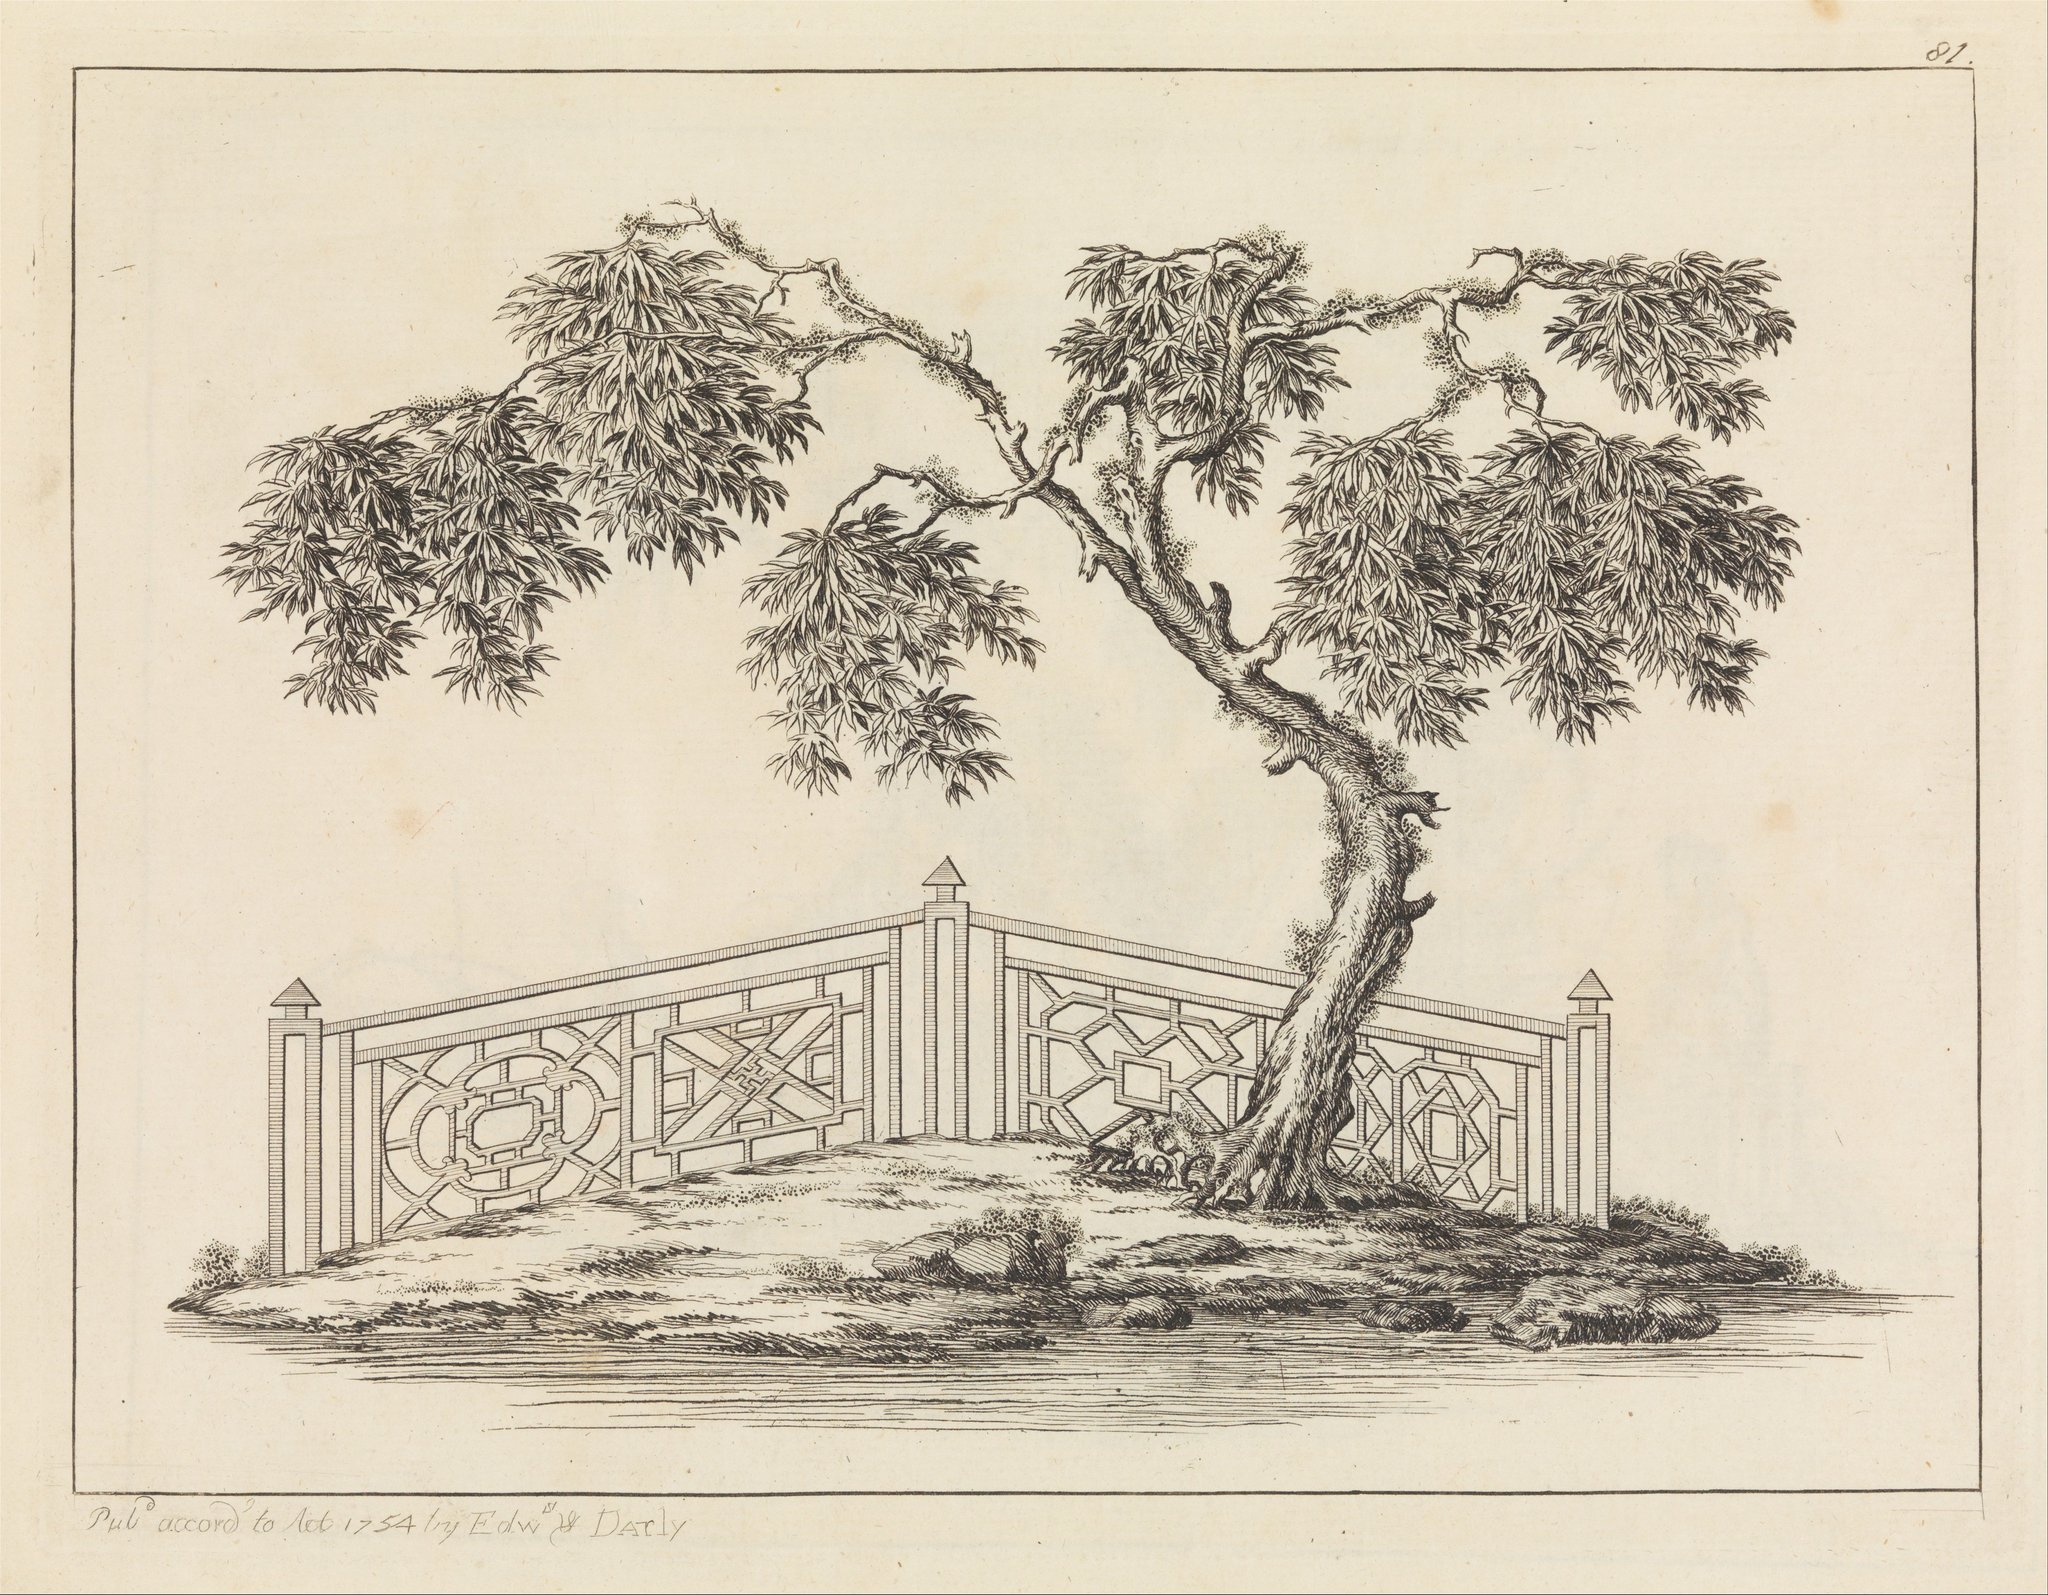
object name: book print ornament architecture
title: A New Book of Chinese Designs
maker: matthias darly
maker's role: artist and publisher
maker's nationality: british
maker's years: 1720-1780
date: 1754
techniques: engraving, etching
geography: england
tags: fences,trees